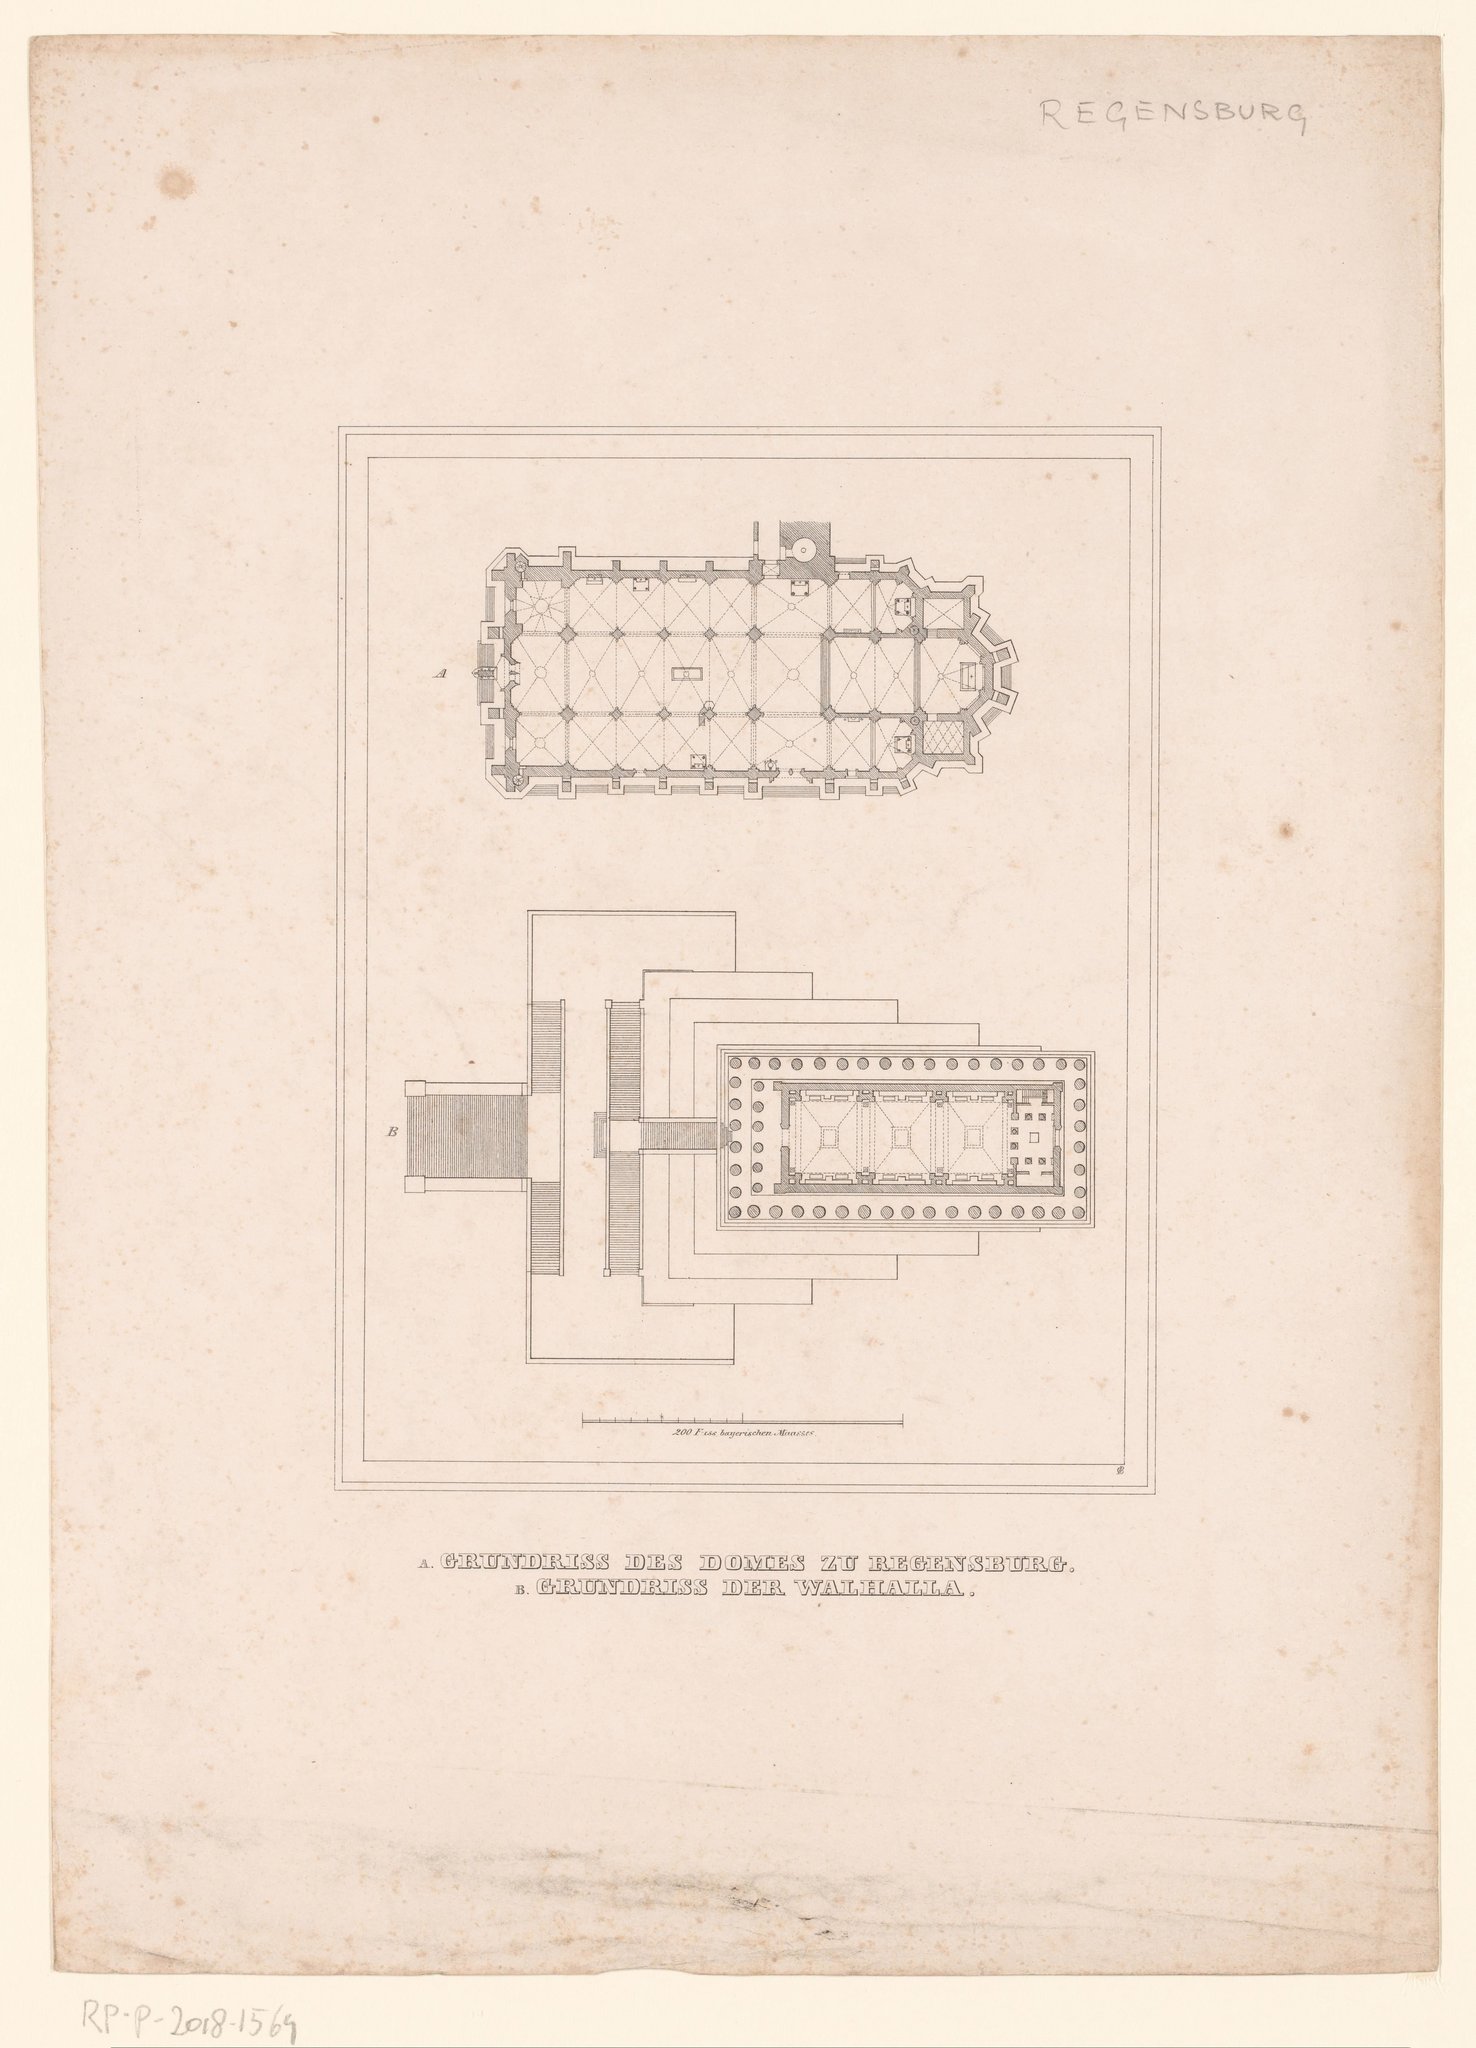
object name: area plan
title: Twee plattegronden van de Dom van Regensburg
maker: monogrammist cb (graveur)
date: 1800-1899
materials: paper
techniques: etching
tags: interior of church, plan ~ architecture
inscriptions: collector's mark: Lugt 2228